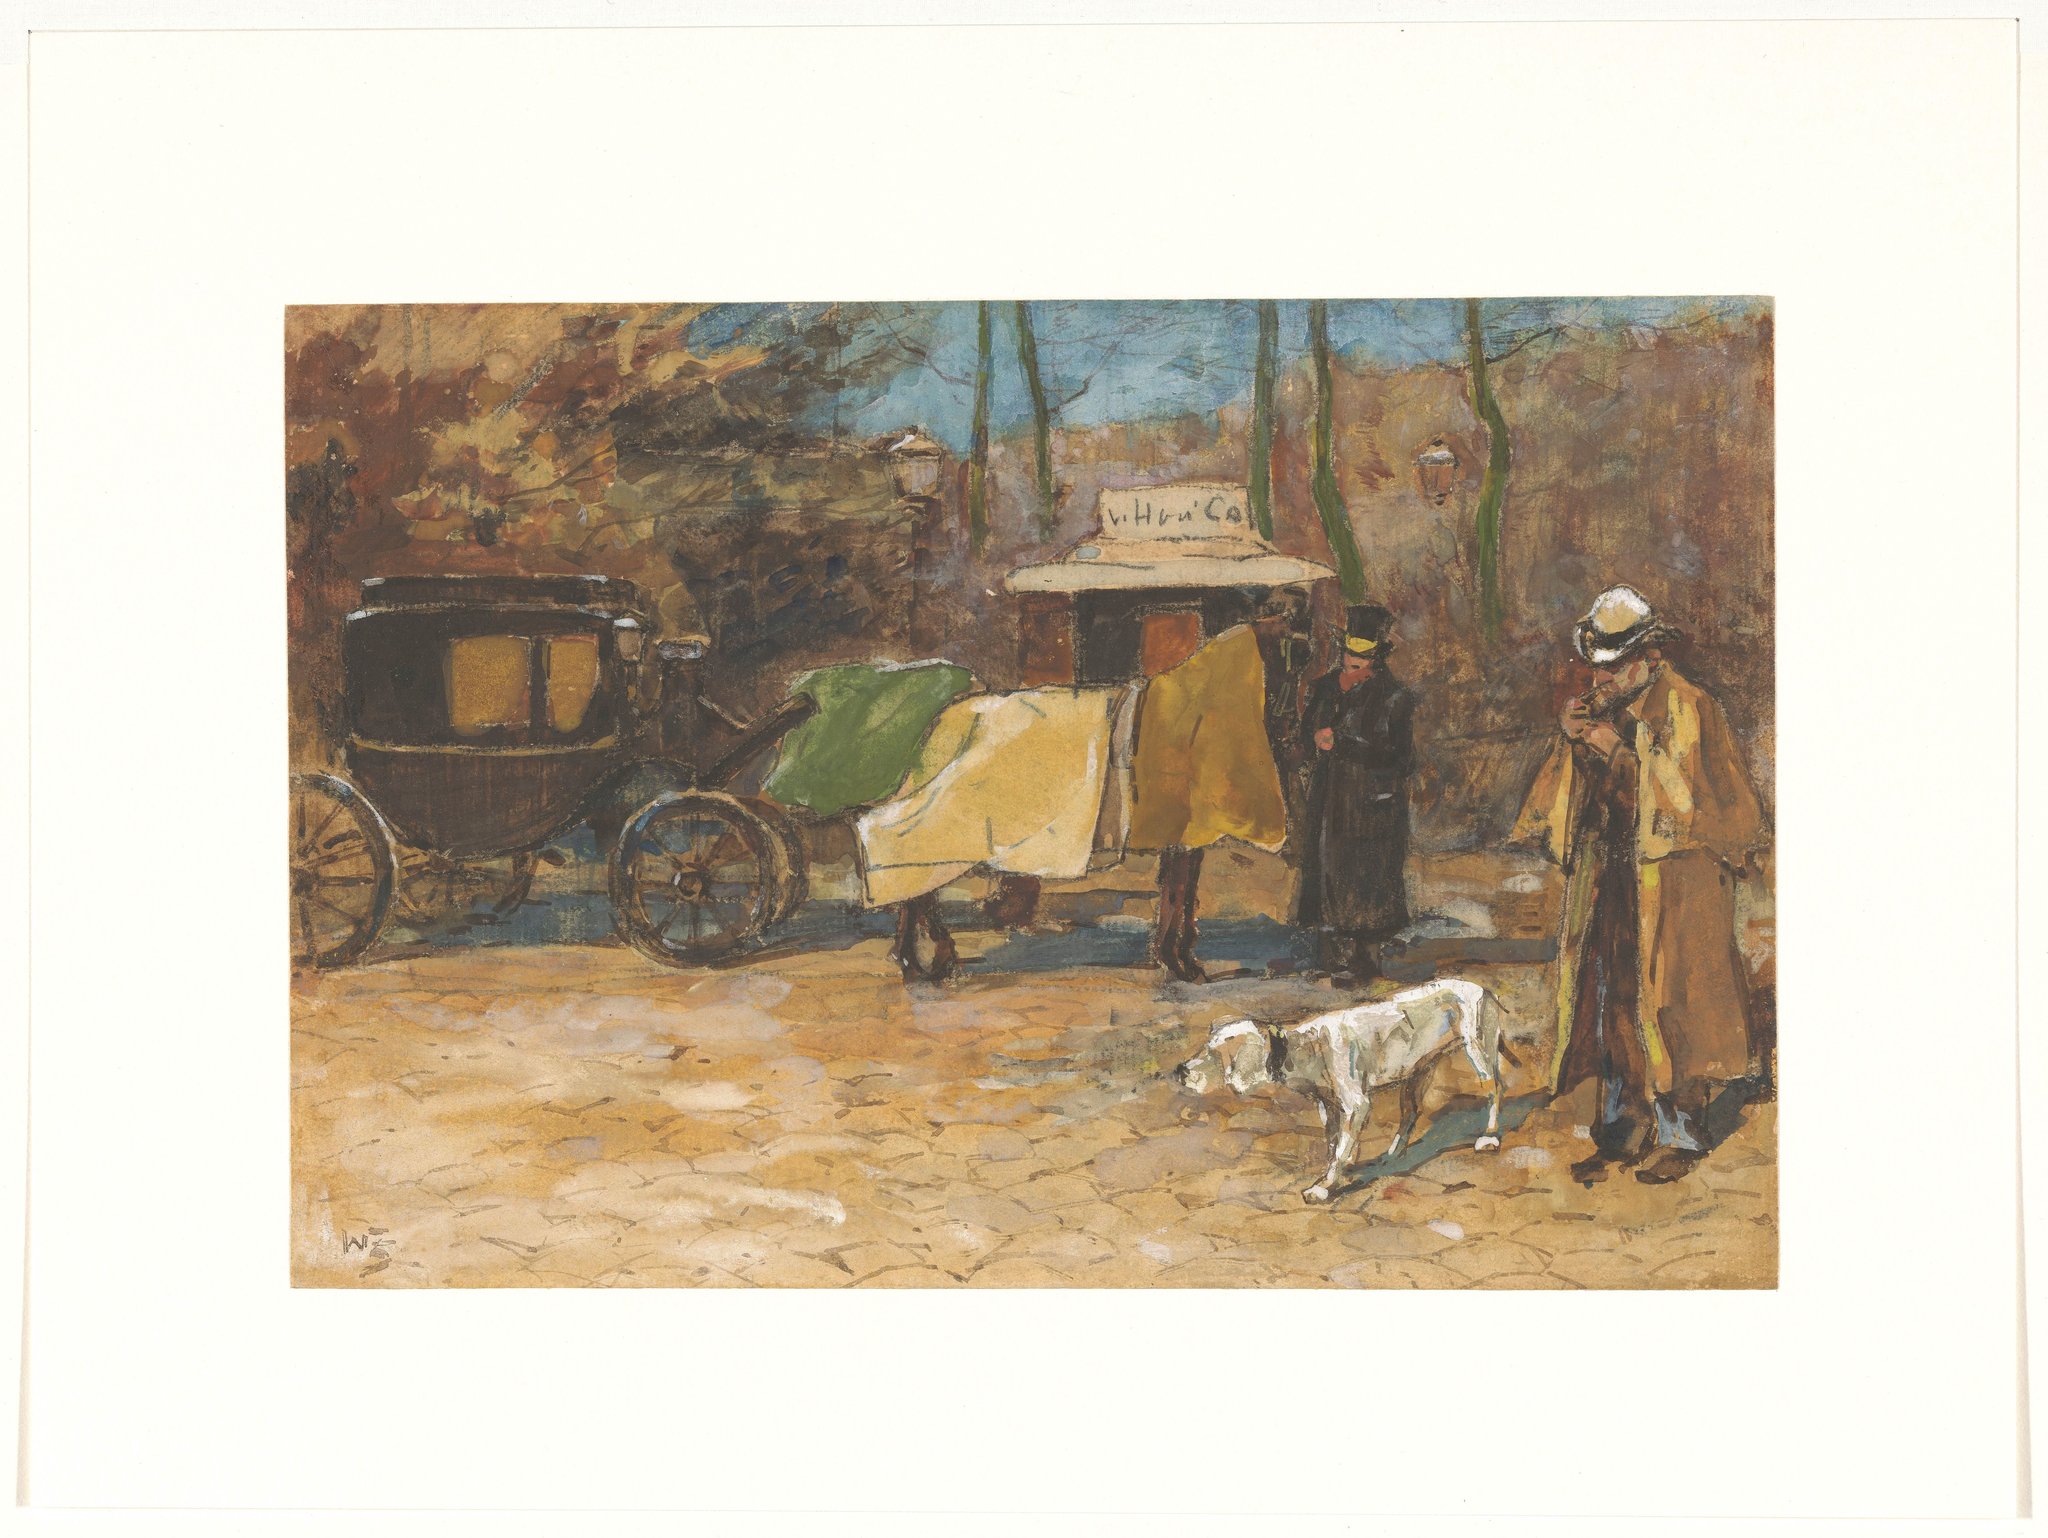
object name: watercolor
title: Wachtend rijtuig in een park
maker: willem de zwart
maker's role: draughtsman, painter, print maker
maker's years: 1862-1931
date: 1872-1931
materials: chalk, paper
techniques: brush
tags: four-wheeled, animal-drawn vehicle, e.g.: cab, carriage, coach, public gardens, park, dog